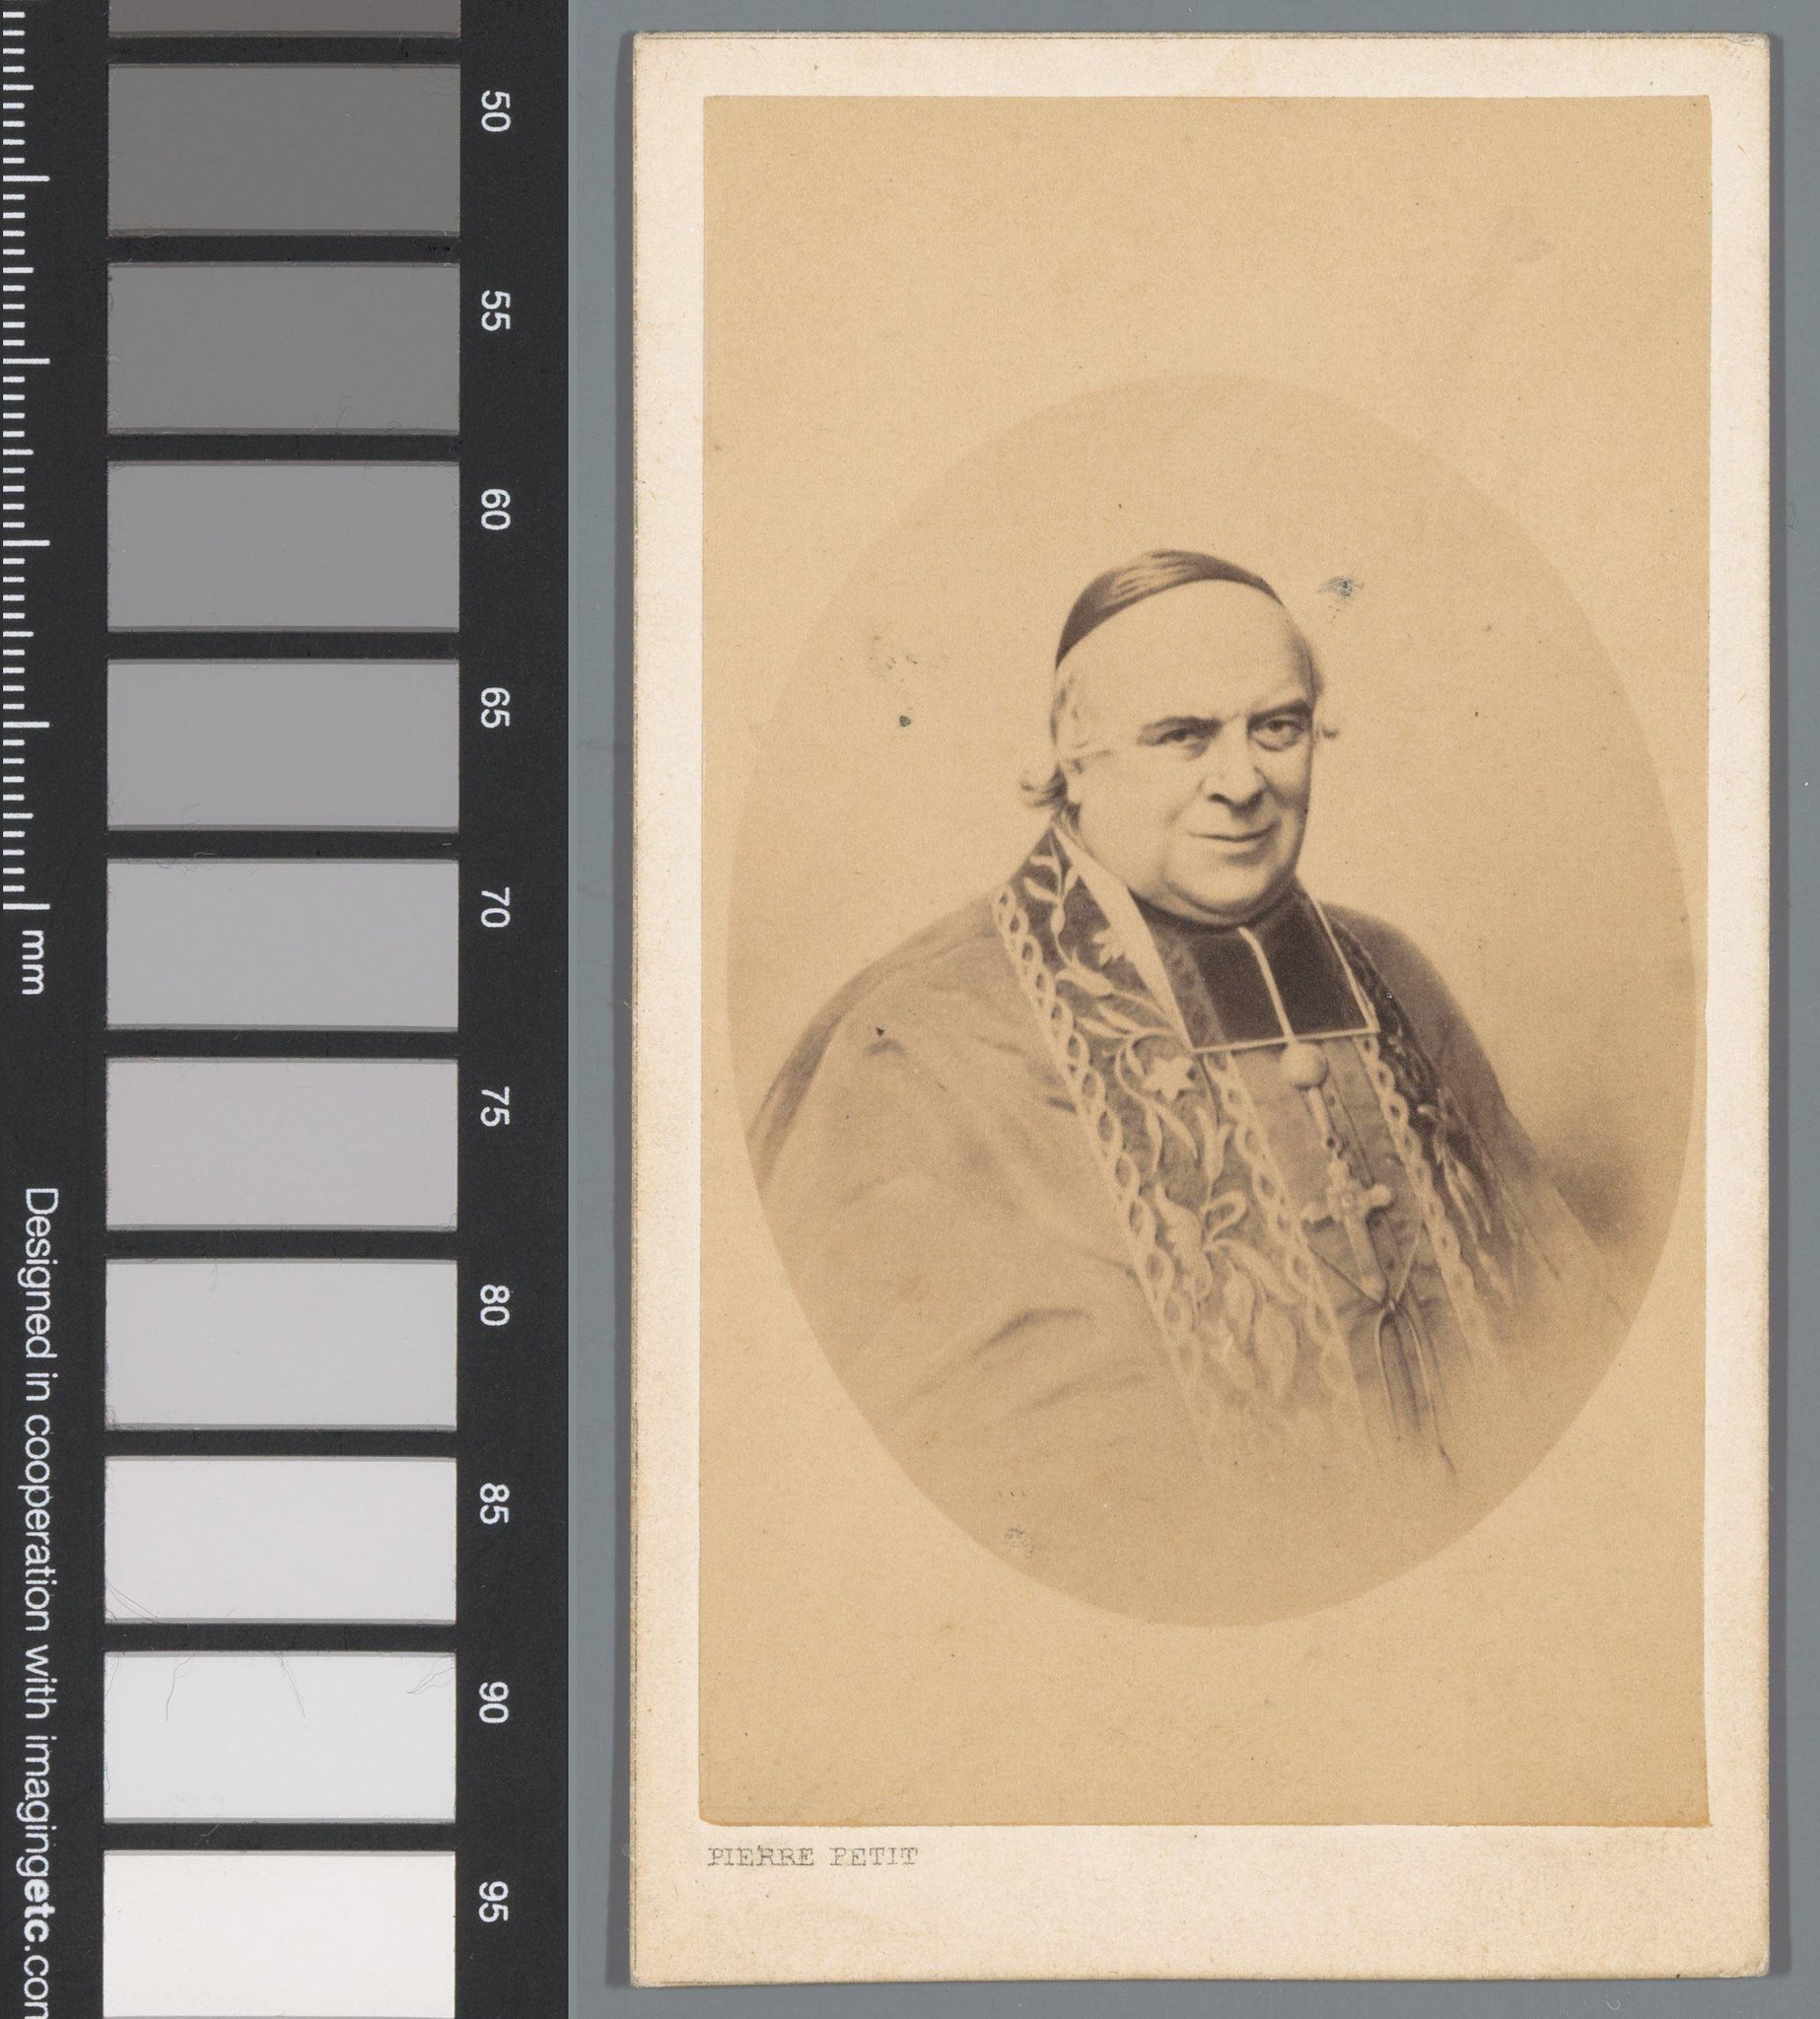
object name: photograph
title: Portret van een onbekende geestelijke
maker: pierre petit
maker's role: fotograaf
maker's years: 1832-1909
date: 1860-1875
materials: cardboard, paper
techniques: albumen print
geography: paris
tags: adult man, historical persons, organization, functionaries and dignitaries in roman catholic church; clergy in general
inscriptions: inscription: ‘PHOTOGRAPHIE DES DEUX MONDES/ EXPOSITION UNIVERSELLE/ PARIS BESANÇON/ PIERRE PETIT/ PHOTOGRAPHE/ 31. PLACE CADET./ PARIS/ PRUSSE BADE’